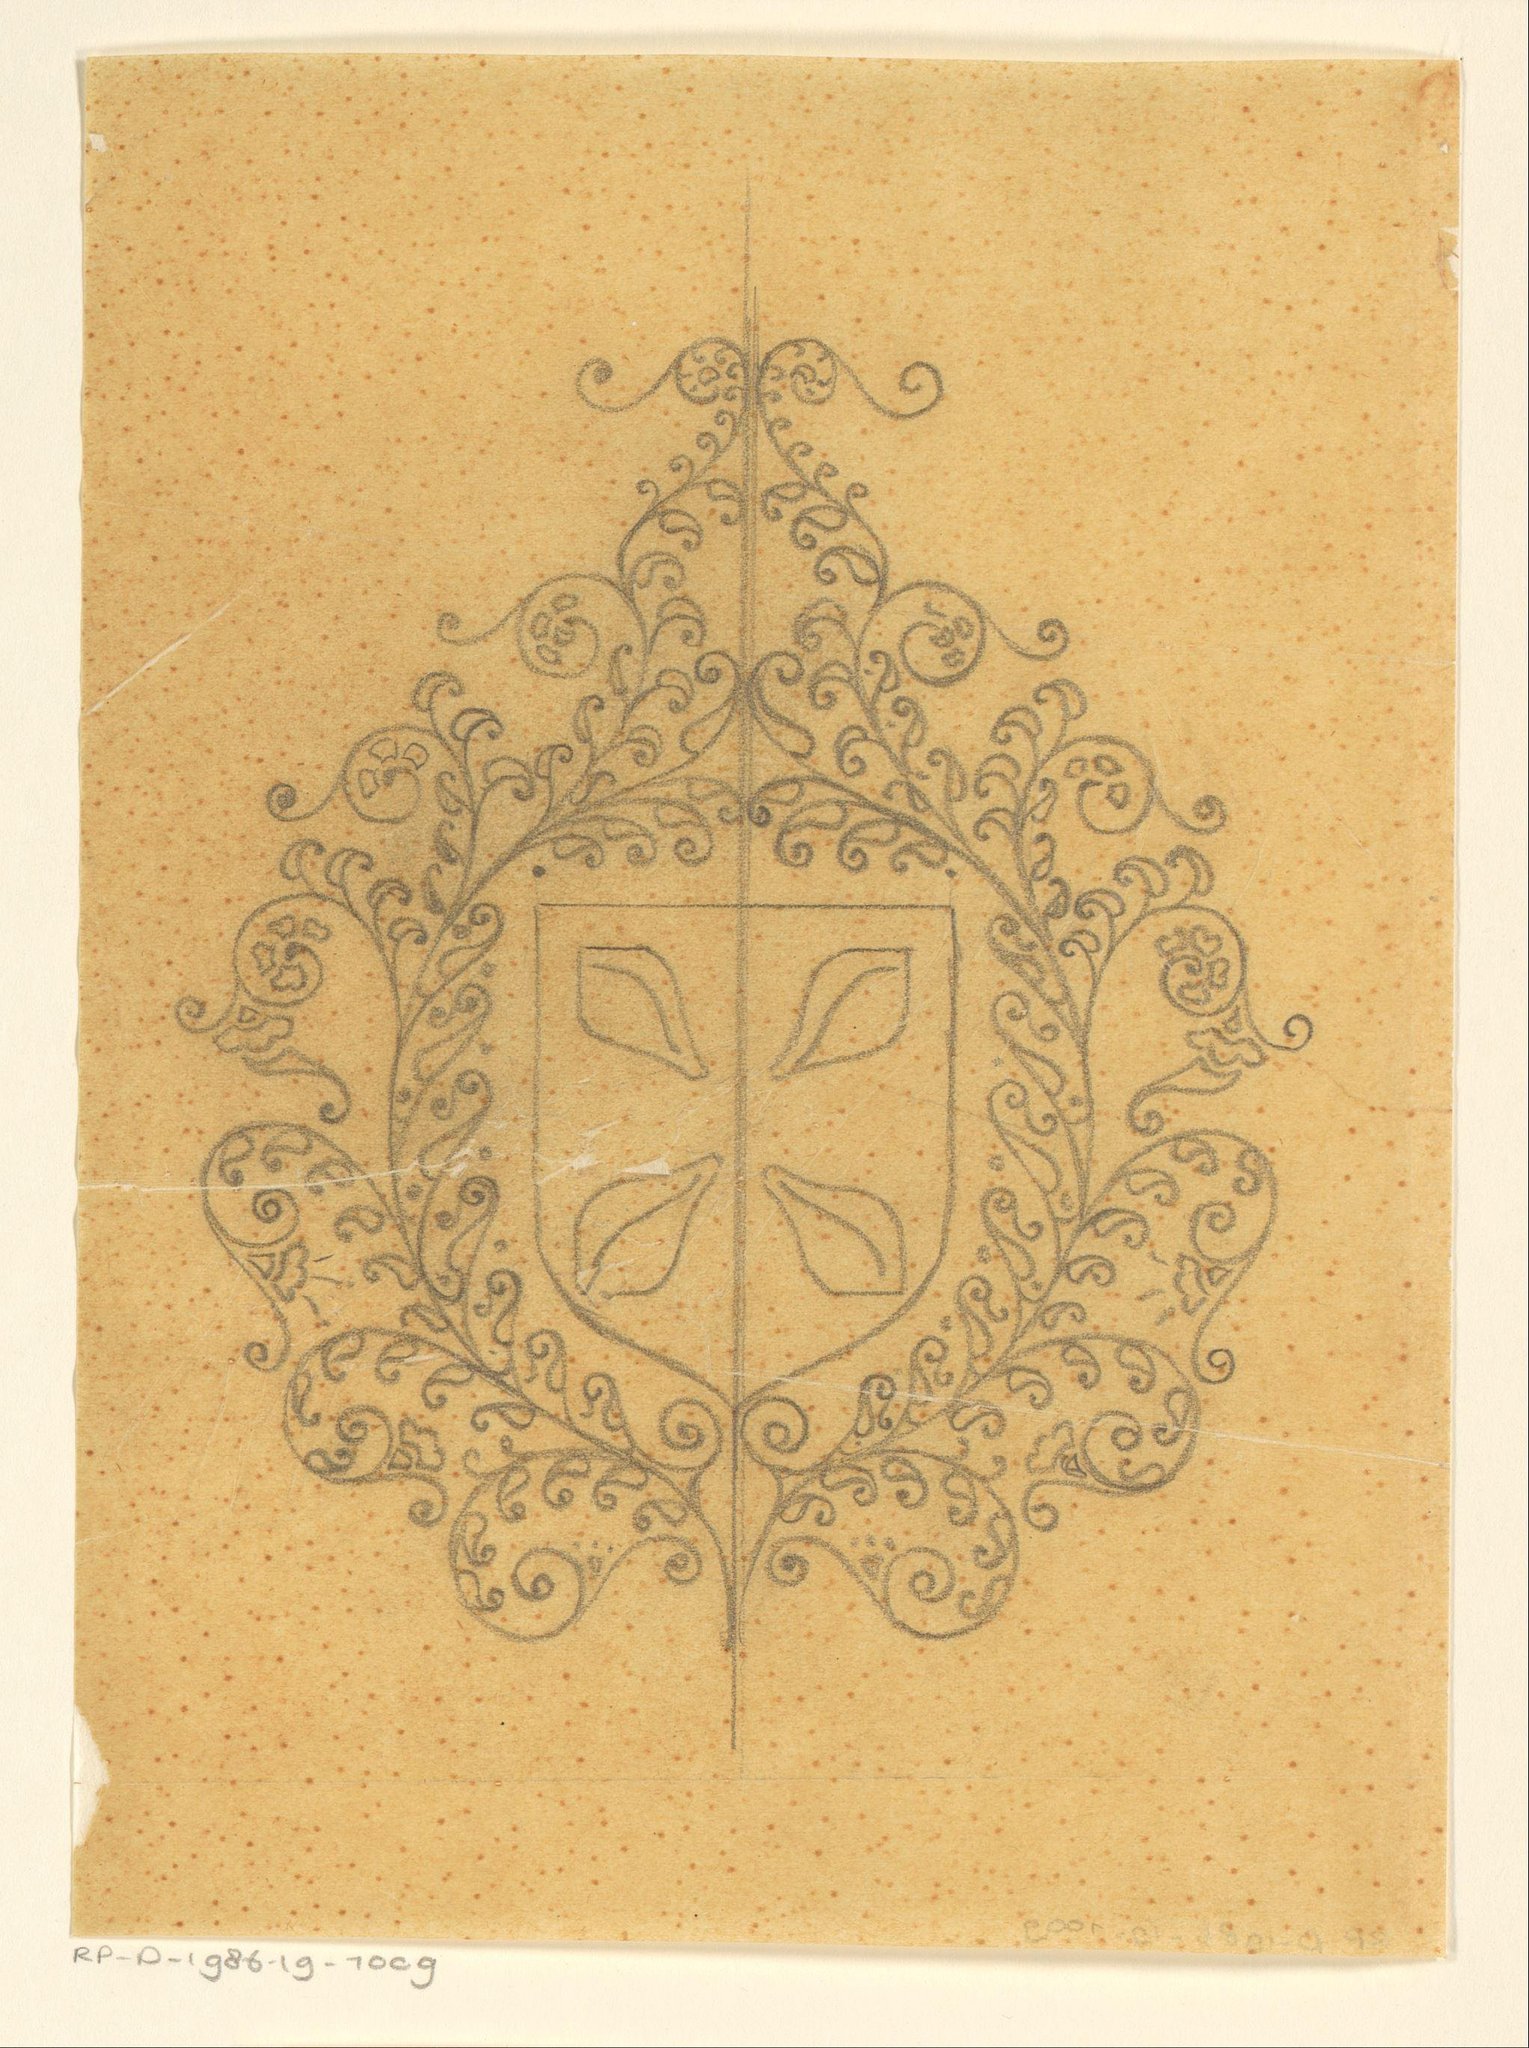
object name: design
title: Wapen van Hilversum met bloemornamenten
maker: reinier willem petrus de vries (1874-1953)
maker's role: draughtsman, print maker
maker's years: 1874-1953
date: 1924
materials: pencil, paper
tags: coat of arms (as symbol of the state, etc.) (+ city; municipal), flowers ~ ornament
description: Ontwerp voor: Ravesteijn, P.J. Gedenkboek Hilversum 1424-1924. Hilversum: Gemeente Hilversum, 1924.